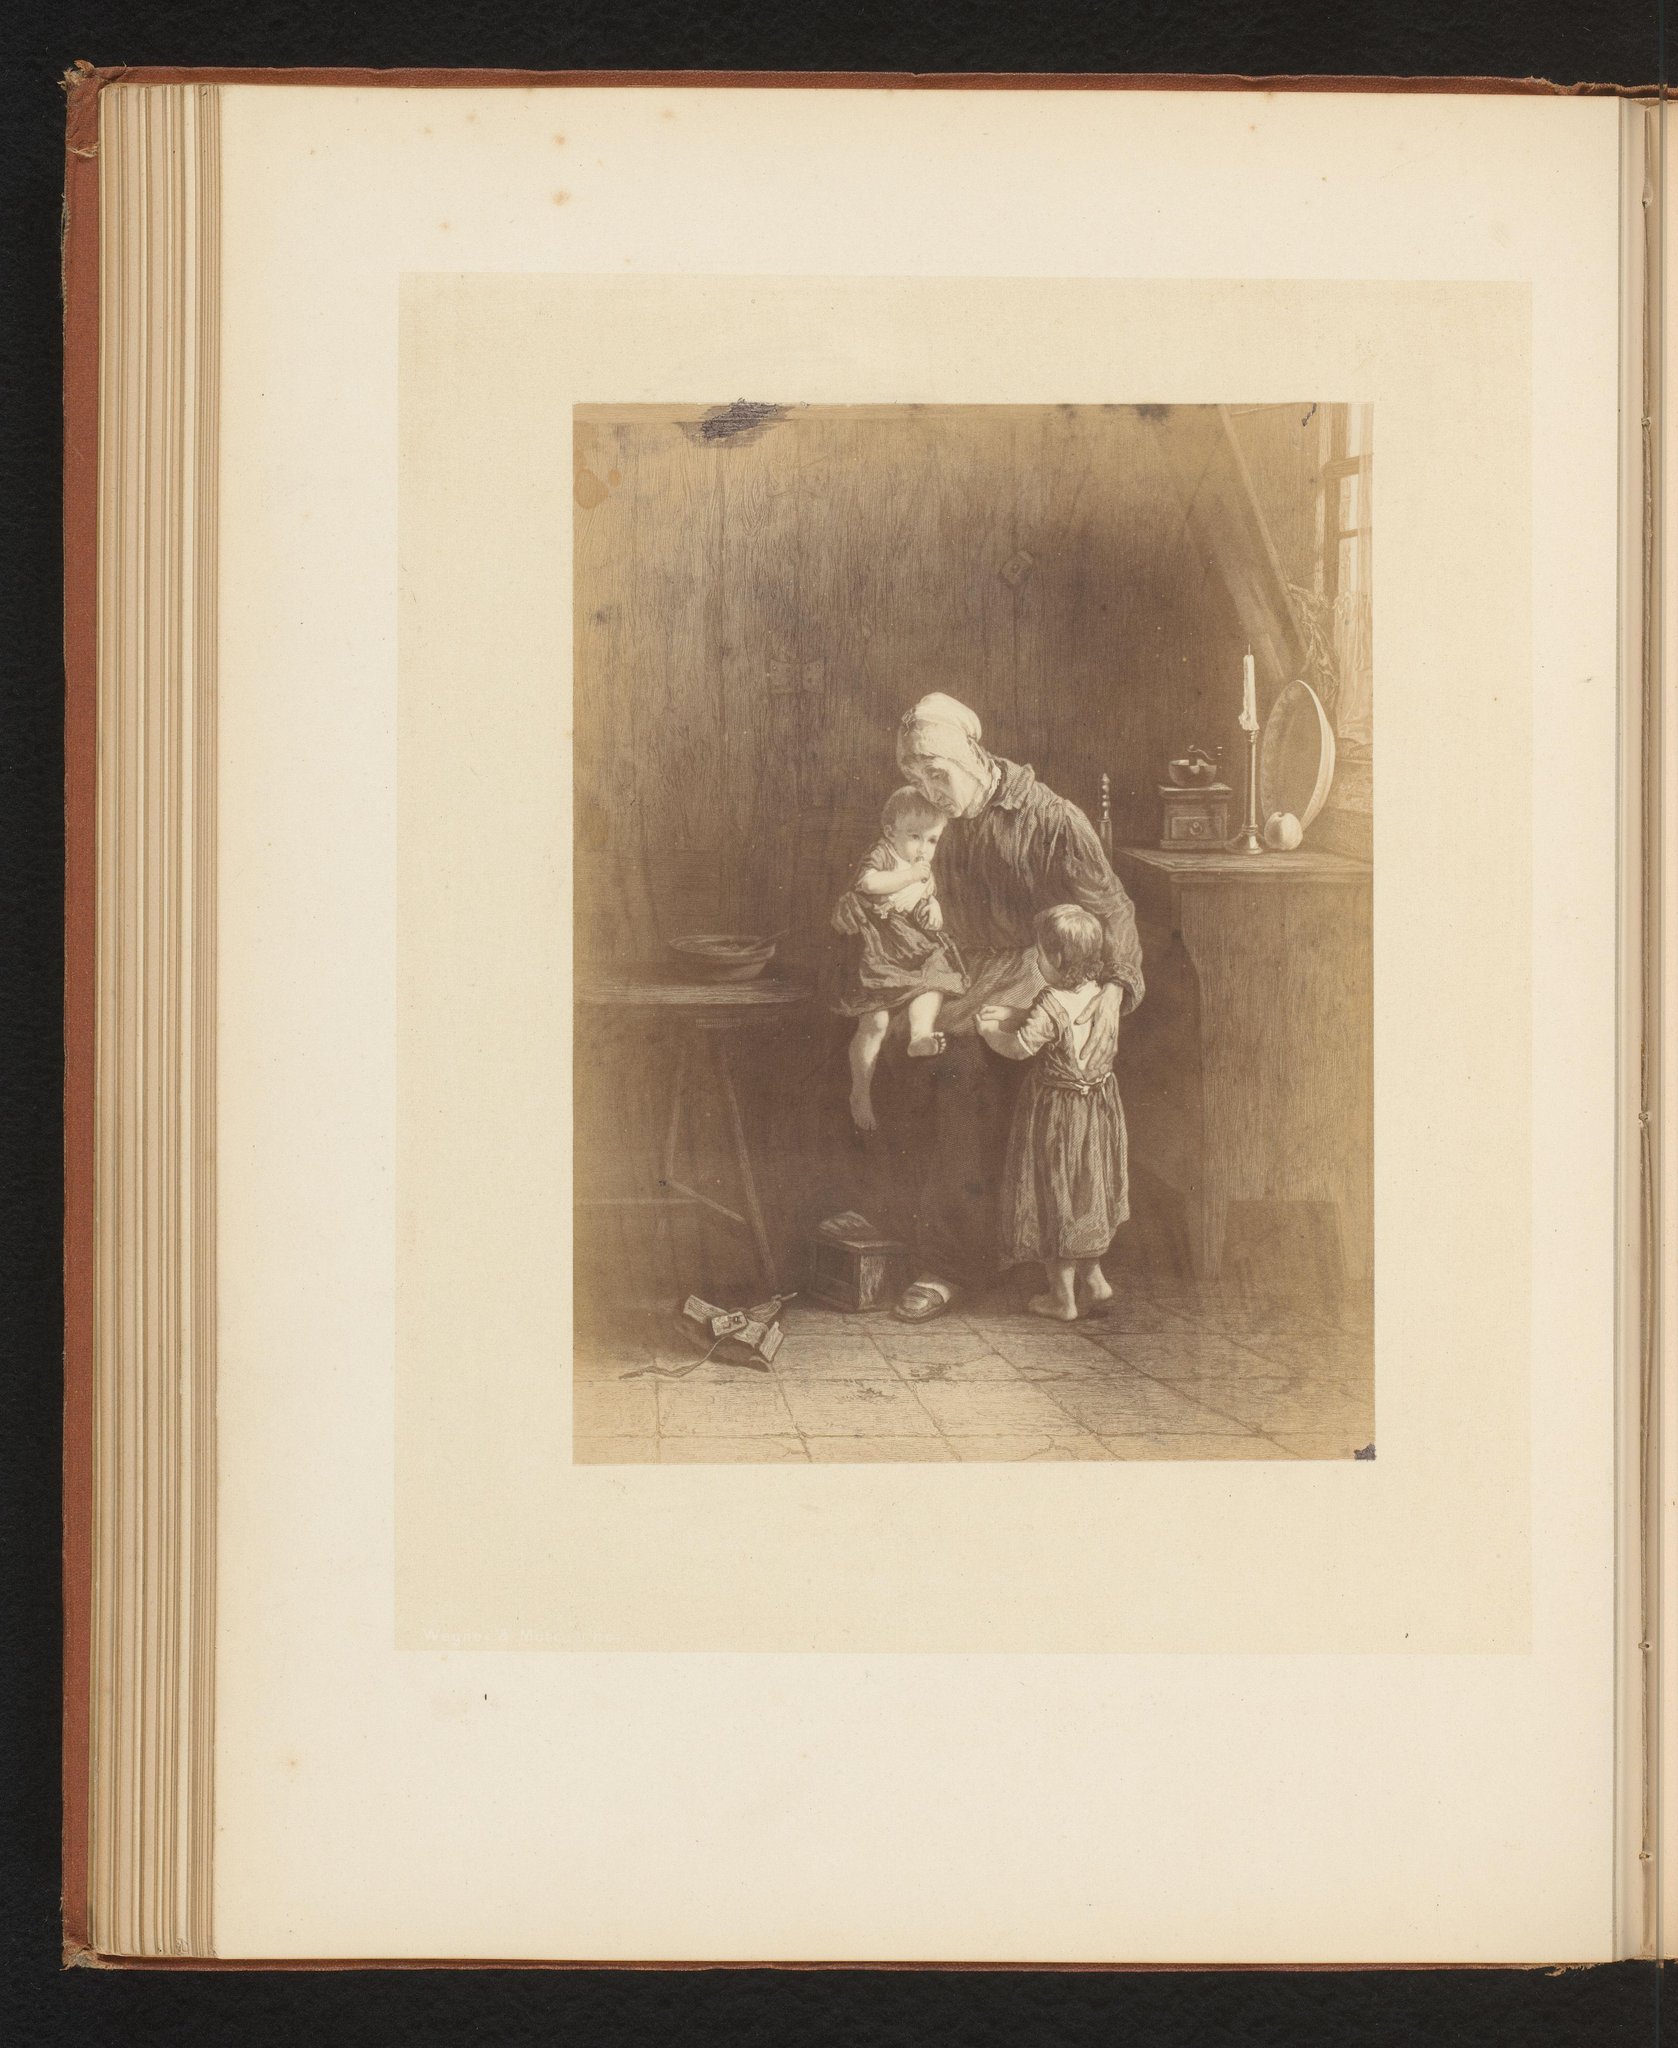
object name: page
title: Fotoreproductie van een gravure naar een schilderij door Jozef Israëls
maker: jozef israëls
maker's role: draughtsman, painter, print maker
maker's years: 1824-1911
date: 1866-1871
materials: paper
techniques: albumen print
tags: print, e.g.: engraving, etching, lithograph